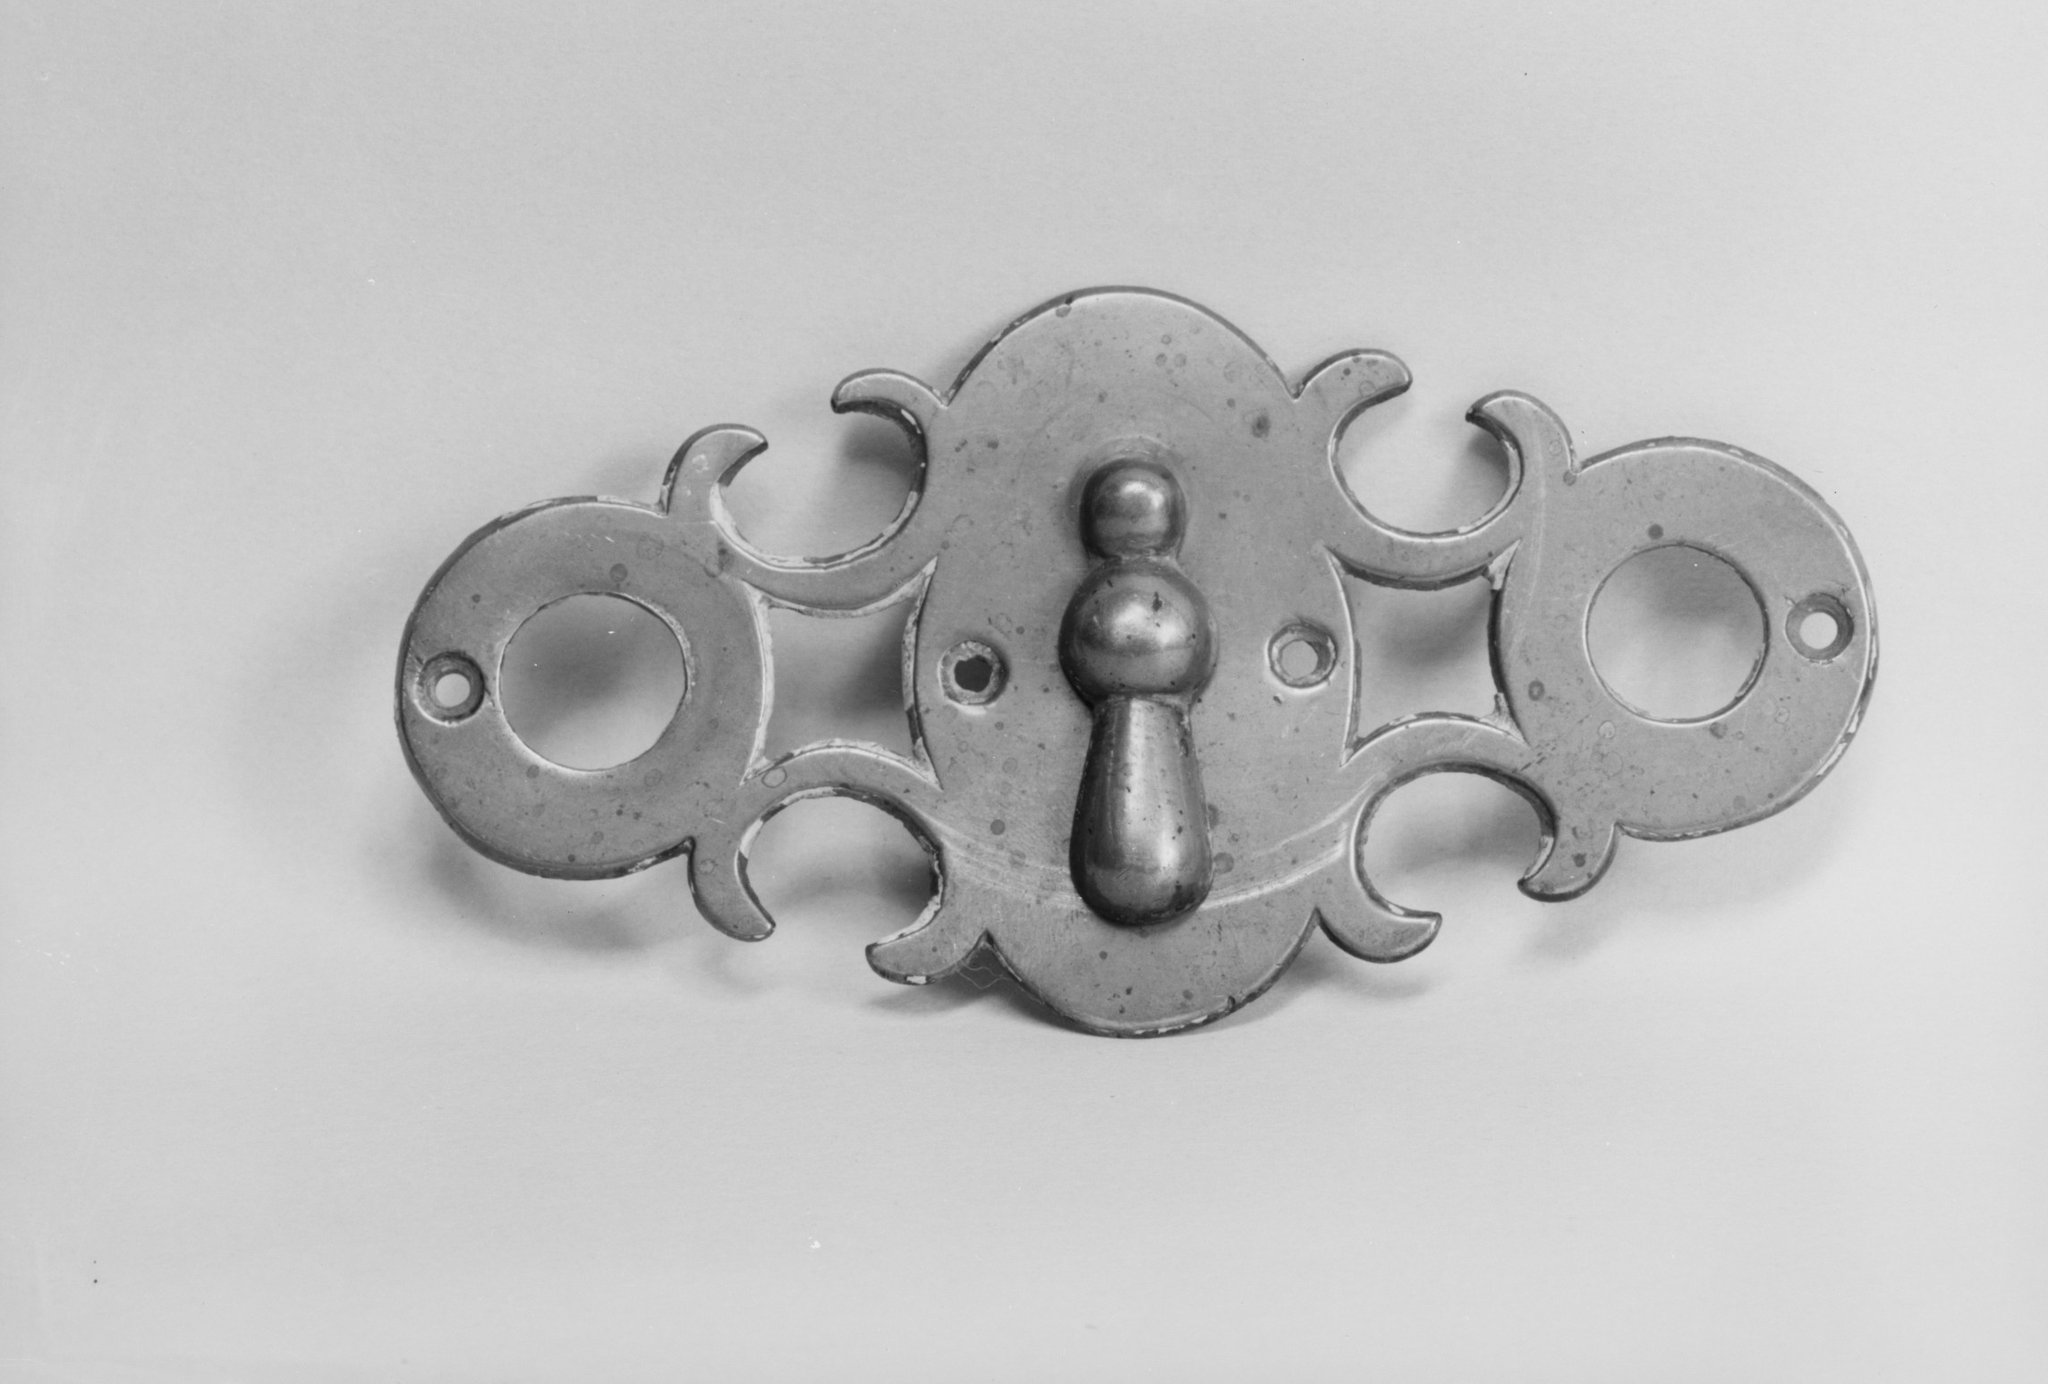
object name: keyhole plate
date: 1700-1800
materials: brass